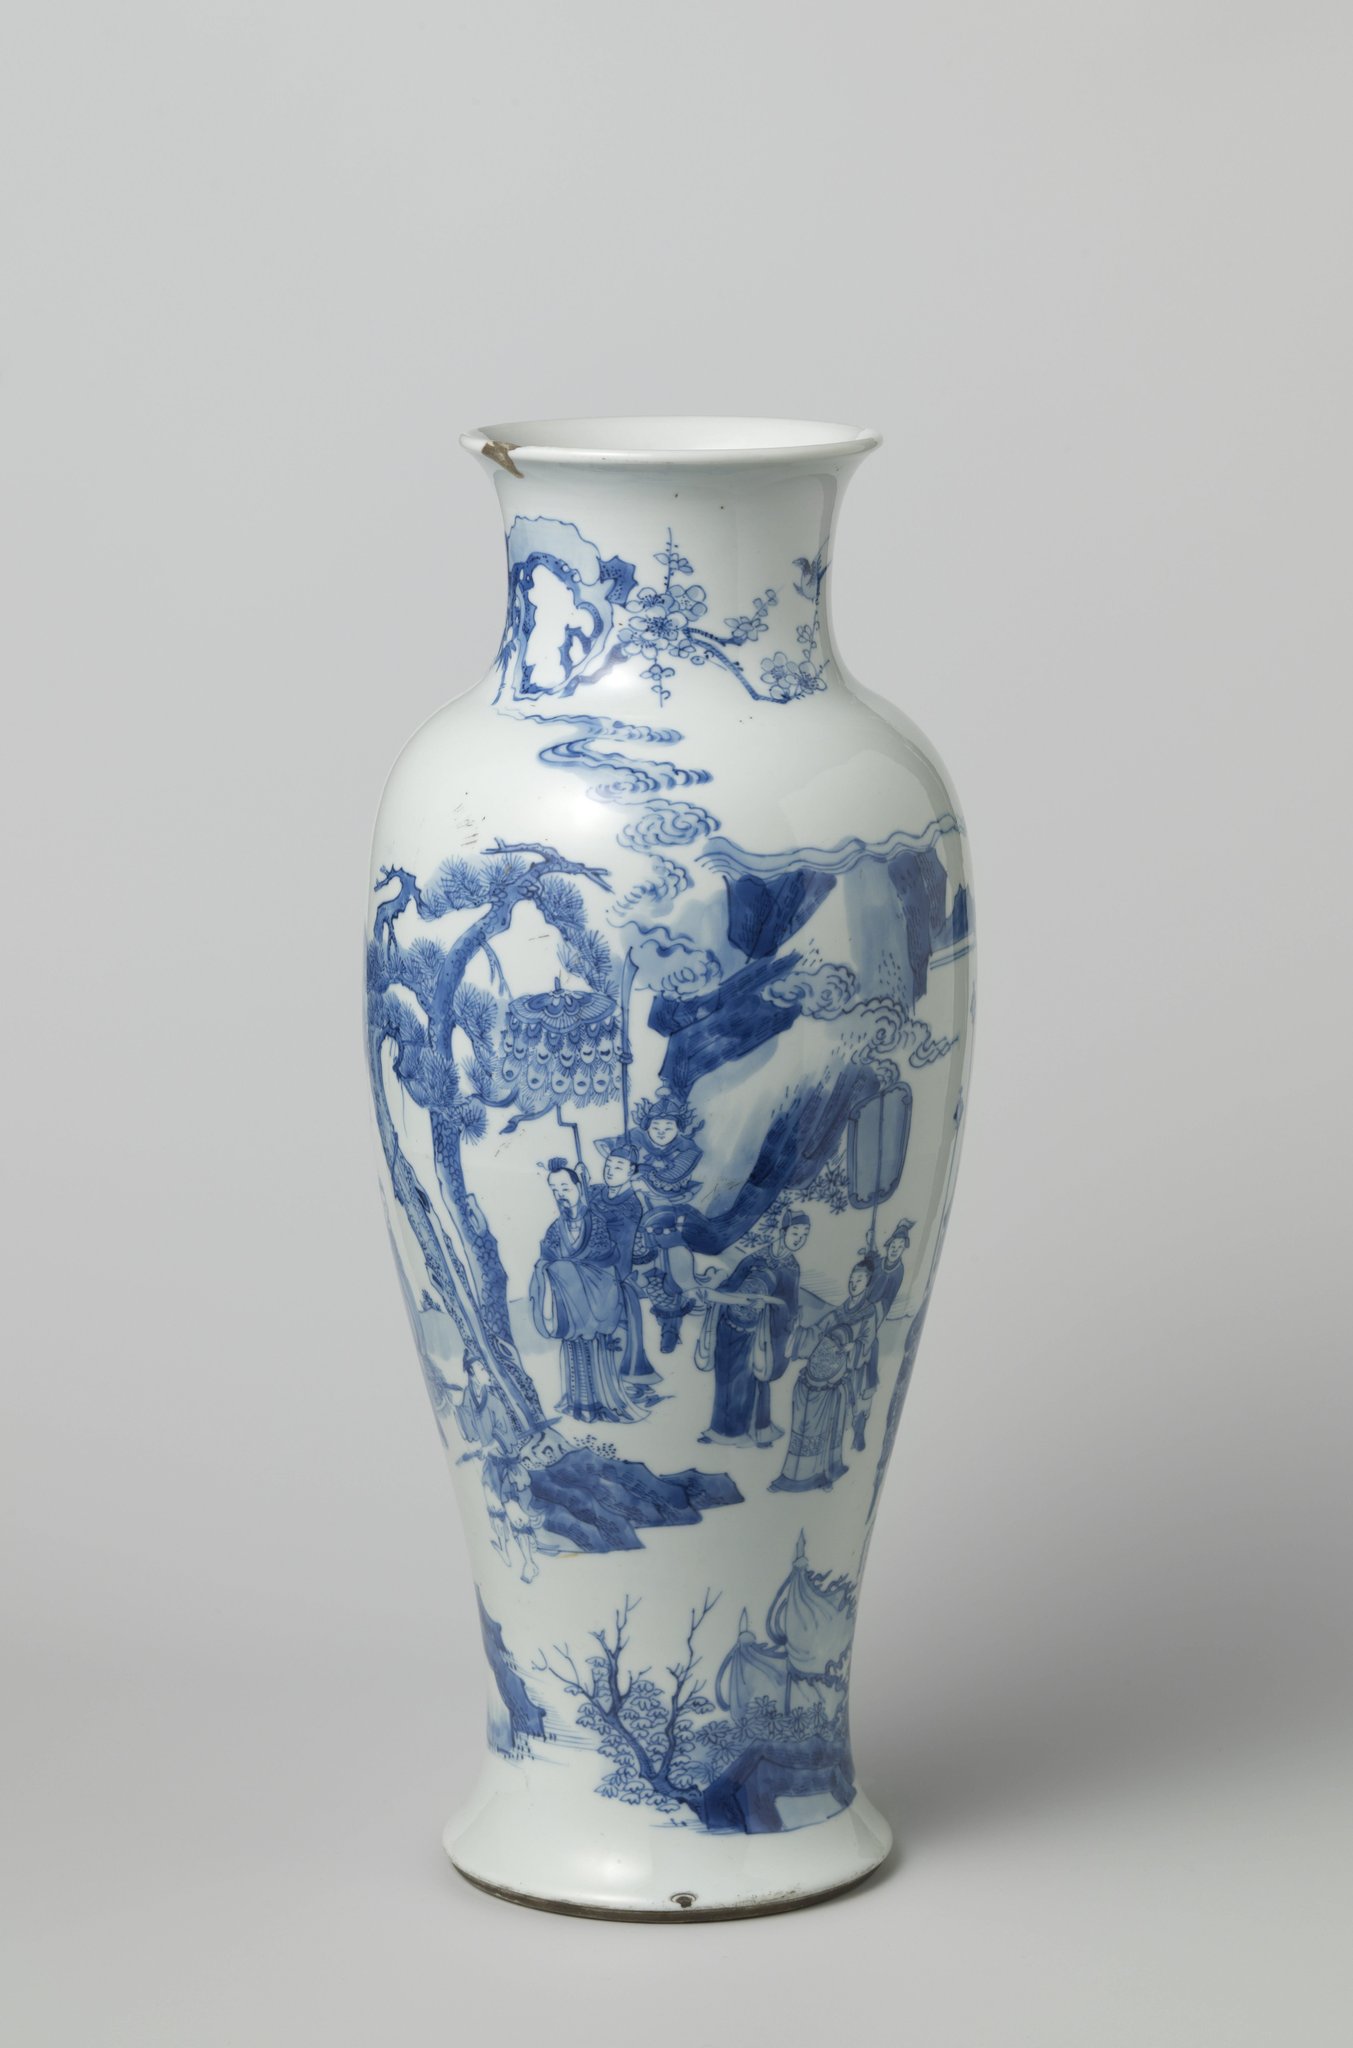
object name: vase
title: Baluster vase with figures in a continuous landscape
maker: Anonymous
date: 1680-1720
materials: cobalt, glaze, paint, porcelain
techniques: firing, turning, vitrification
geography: china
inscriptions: mark: ‘大 明 宣 德 年 製 dà míng Xuān dé nián zhì’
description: Balustervormige vaas van porselein, beschilderd in onderglazuur blauw. Op de wand een doorlopend rivierlandschap met verschillende personen: de ontmoeting van een hoogwaardigheidsbekleder en zijn vrouw met een kluizenaar. De ambtenaar is met gevolg. Op de hals bamboetakken, prunustakken en een rots. Gemerkt met het zes-karaktermerk van keizer Xuande in een dubbele cirkel. Een chip in de rand. Blauw-wit.